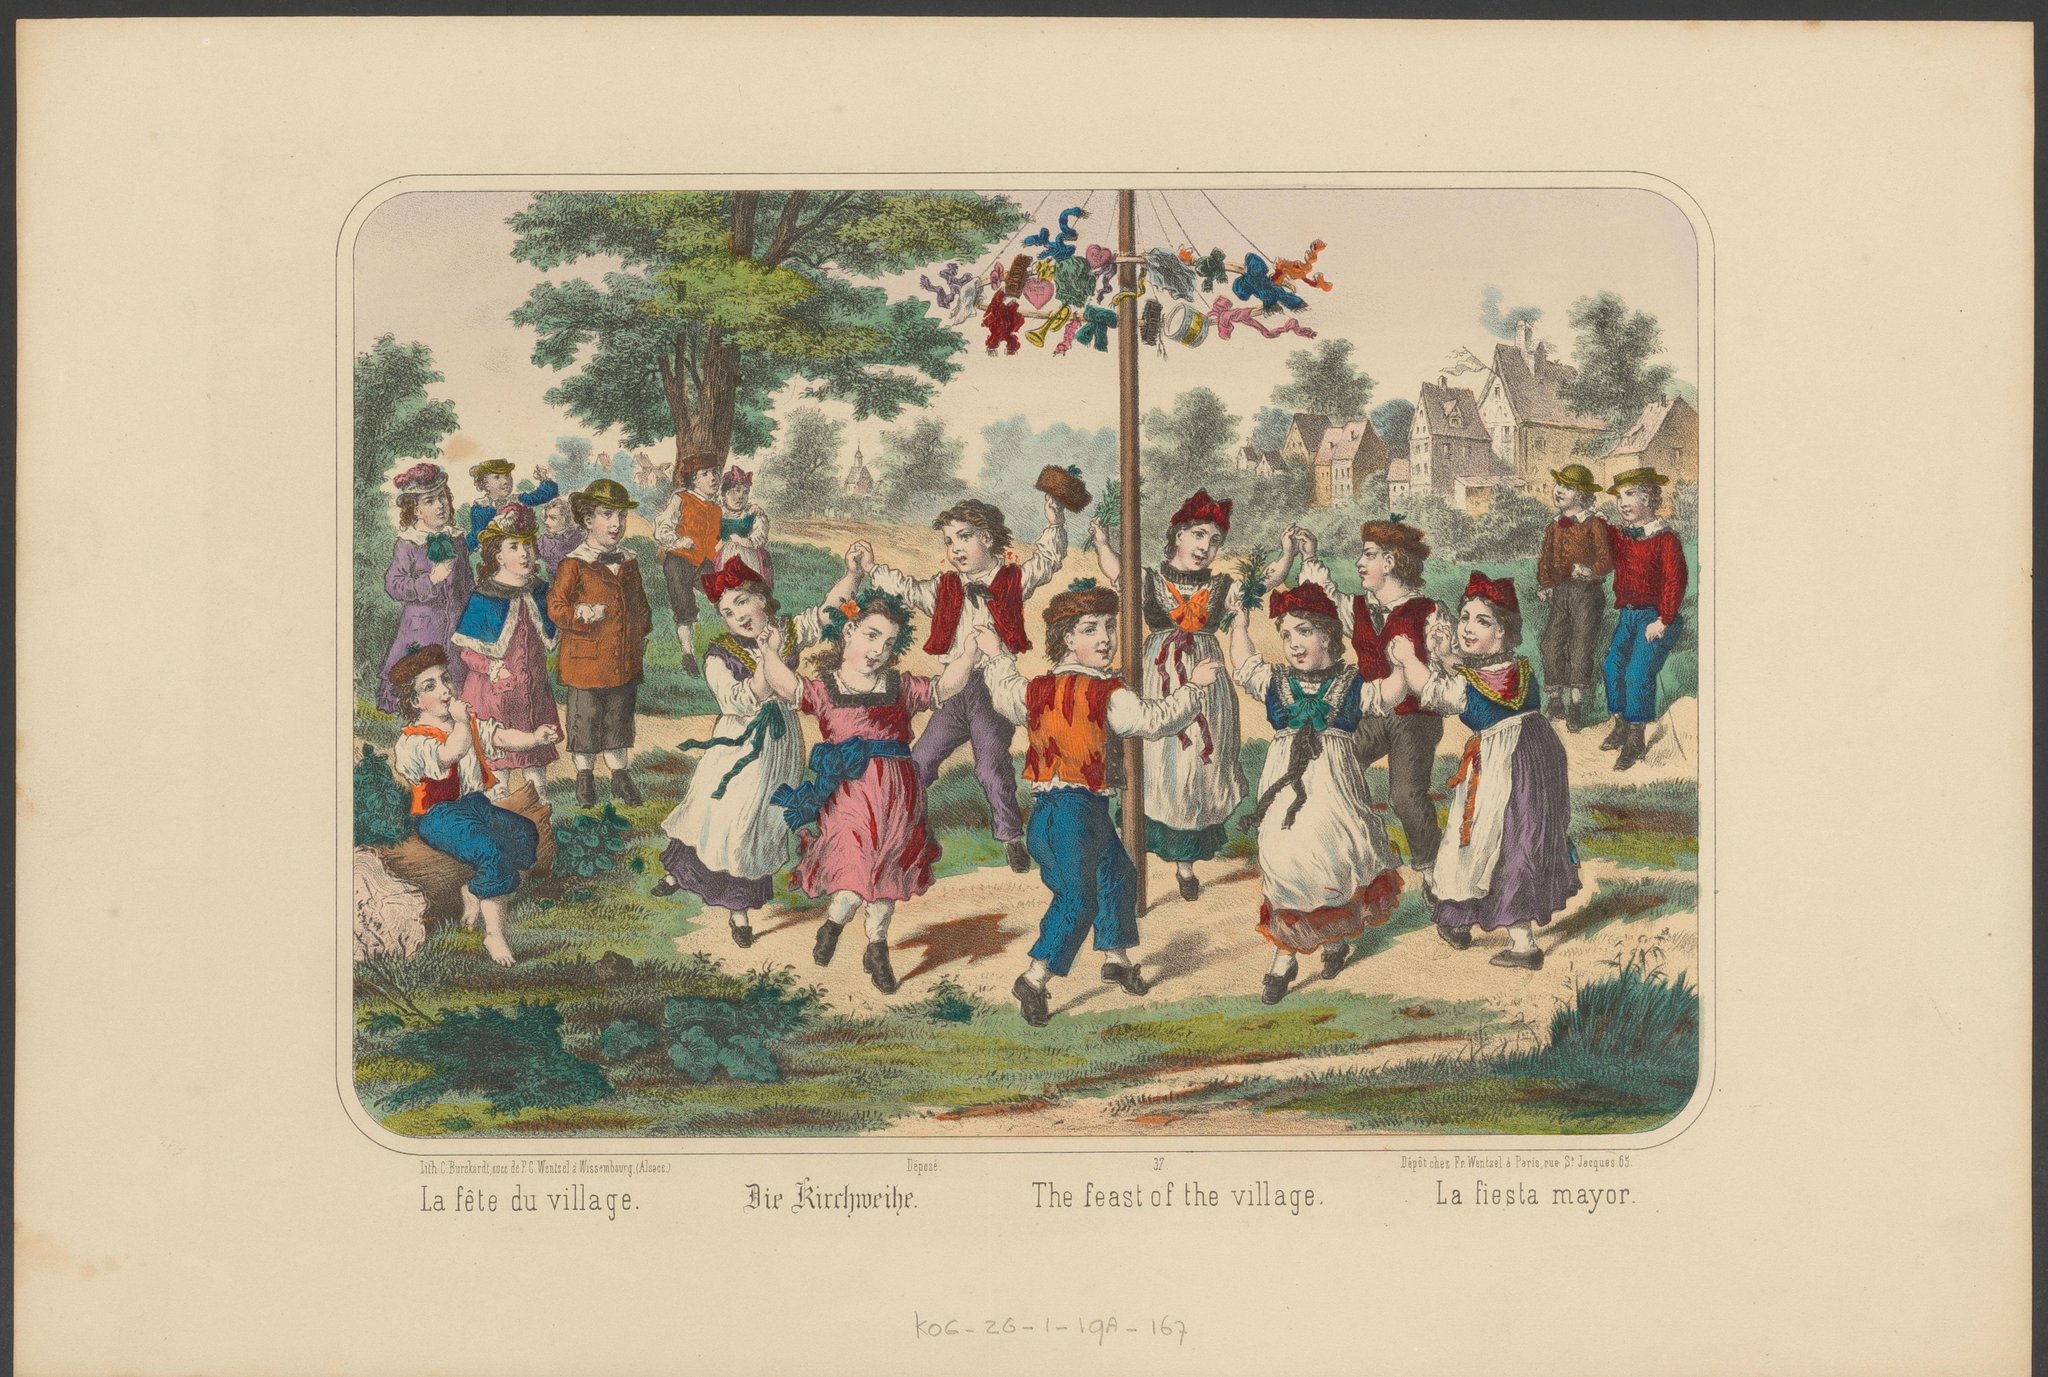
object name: print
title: Le fête du village / Die Kirchweihe / The feast of the village / La fiesta mayor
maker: frédéric charles wentzel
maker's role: print maker, publisher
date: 1850-1899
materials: paper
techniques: hand coloring, lithograph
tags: maypole, children's games and plays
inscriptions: collector's mark: Lugt 1641, : ‘Déposé’, stamp: Lugt 2233, stamp:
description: Onderaan genummerd: 37. Onderwerpsrubrieken binnen de Atlas Zeden en Gewoonten: Zeden en Gewoonten in Engeren Zin, Des menschen beging, midden en einde, Kinderleven – Kinderspel en Kinderprenten.